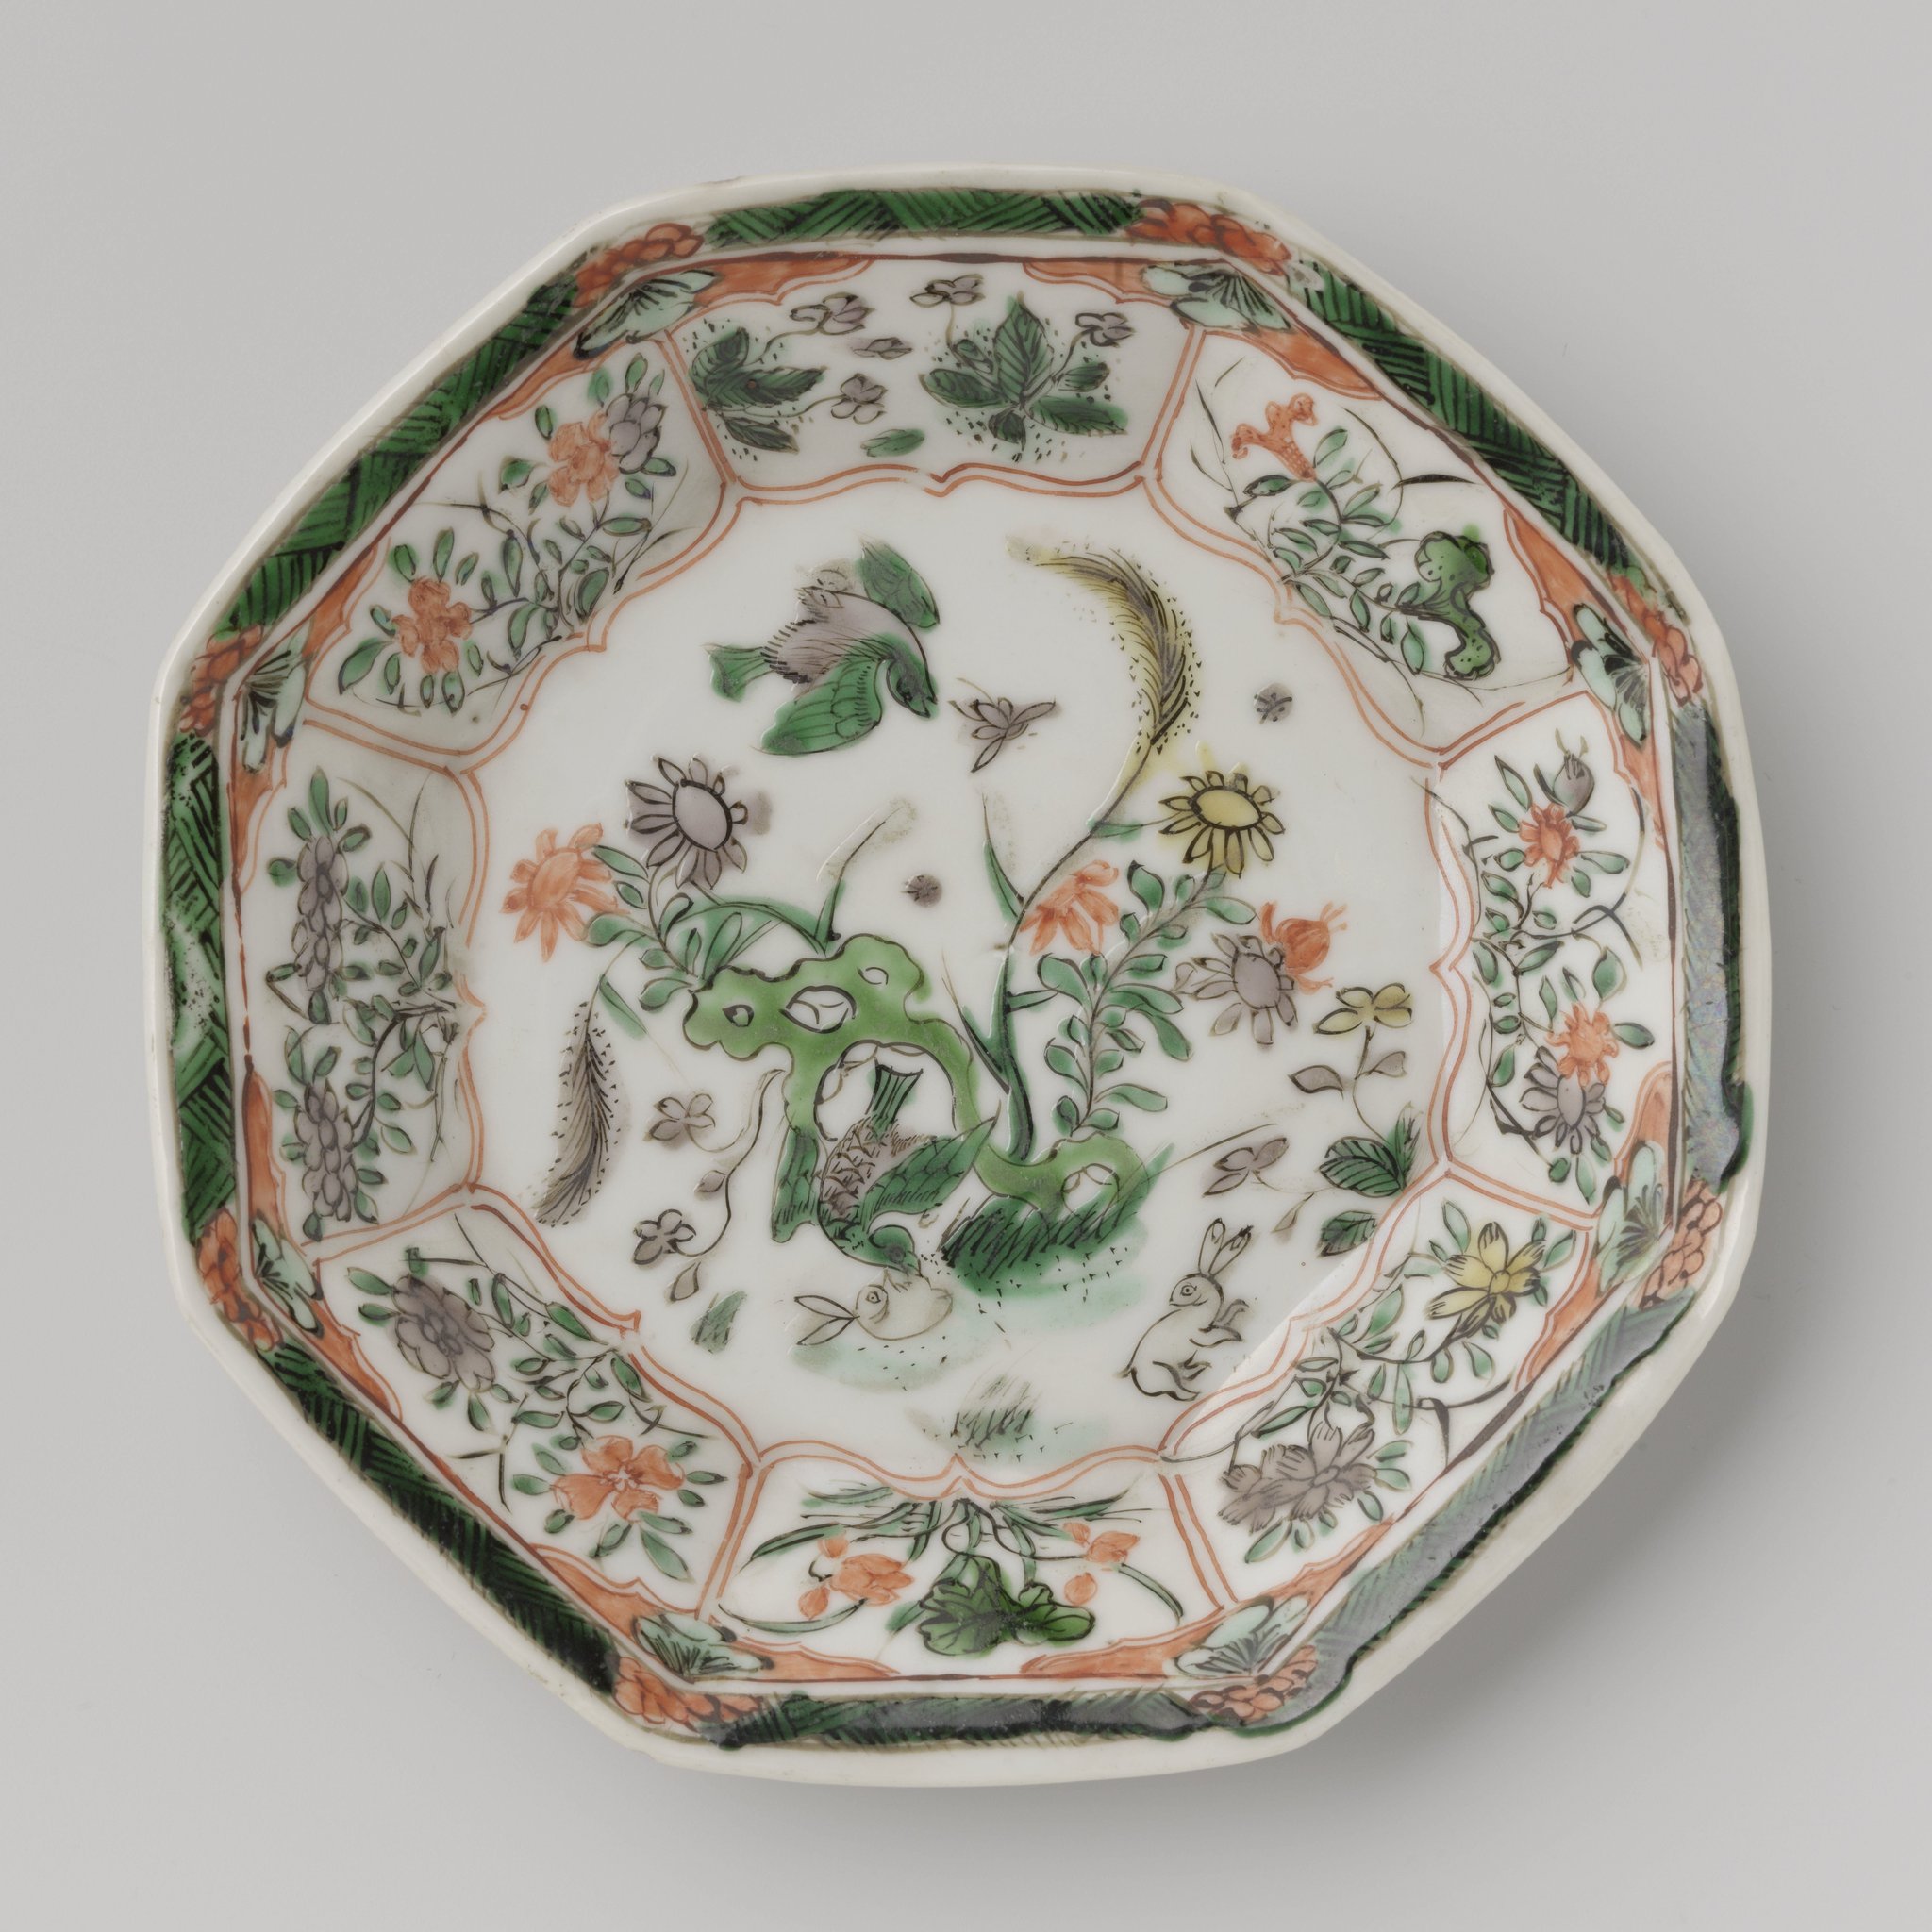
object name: platter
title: Octagonal saucer with light brown, animals and flower sprays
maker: Anonymous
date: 1700-1724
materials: cobalt, glaze, paint, porcelain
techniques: firing, forming, turning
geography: china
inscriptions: mark, mark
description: Kop en schotel, achtkantig, cafe-au-lait, famille verte, met decors van bloeiende planten, haasjes en vogels. Op de buitenzijde zijn op een zeemleerkleurig fond bloempjes in afstekende kleuren aangebracht.